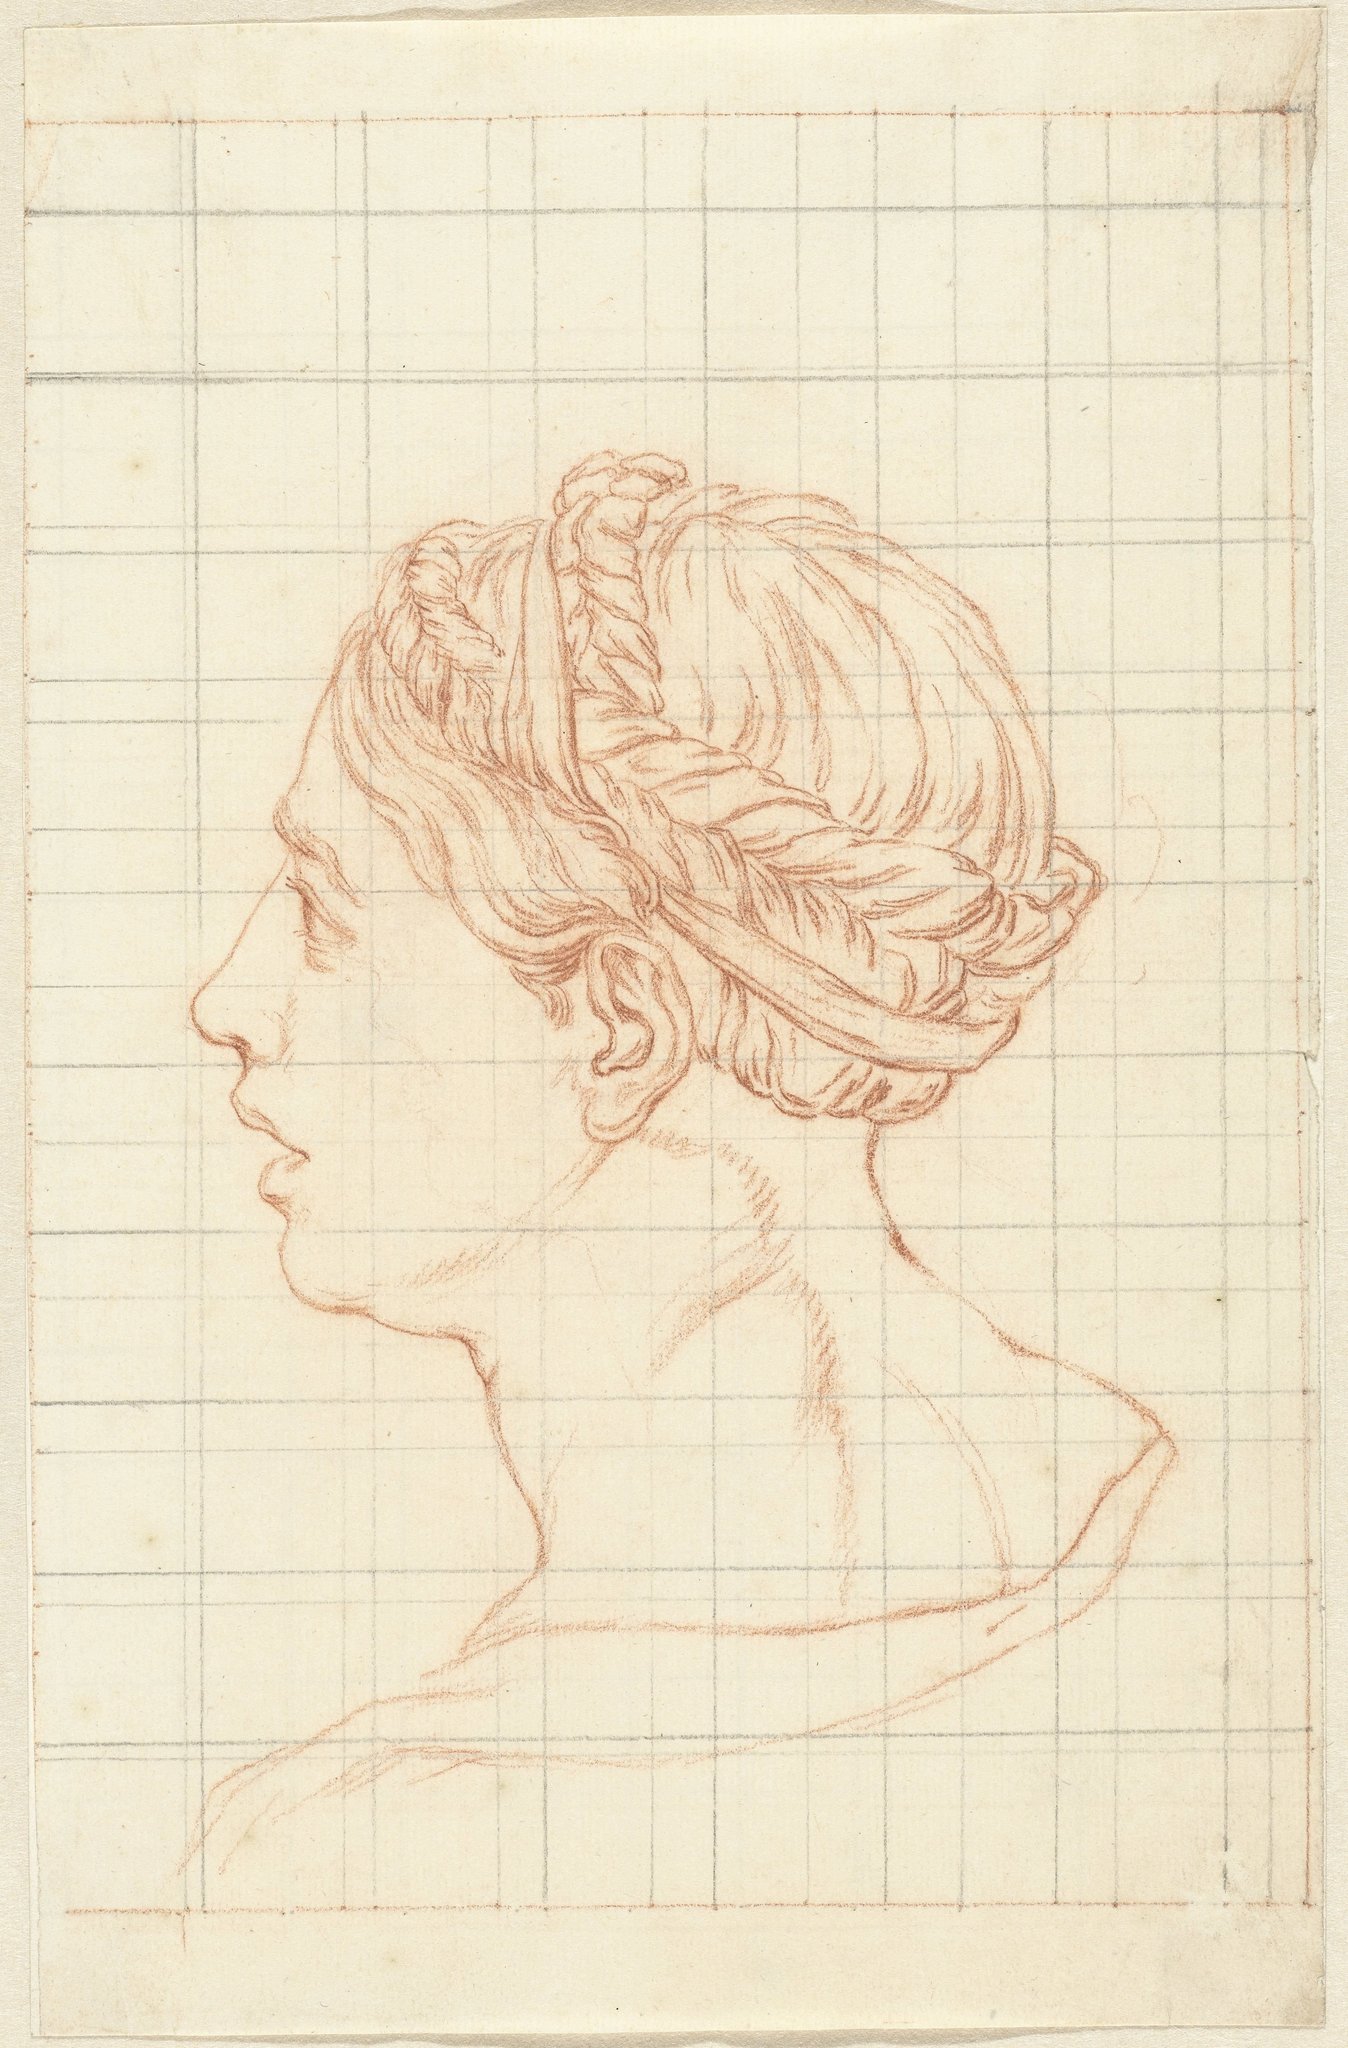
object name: drawing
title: Hoofd van een vrouw, in profiel naar links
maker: bernard picart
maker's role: draughtsman, print maker, publisher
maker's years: 1673-1733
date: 1683-1733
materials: chalk, paper, pencil